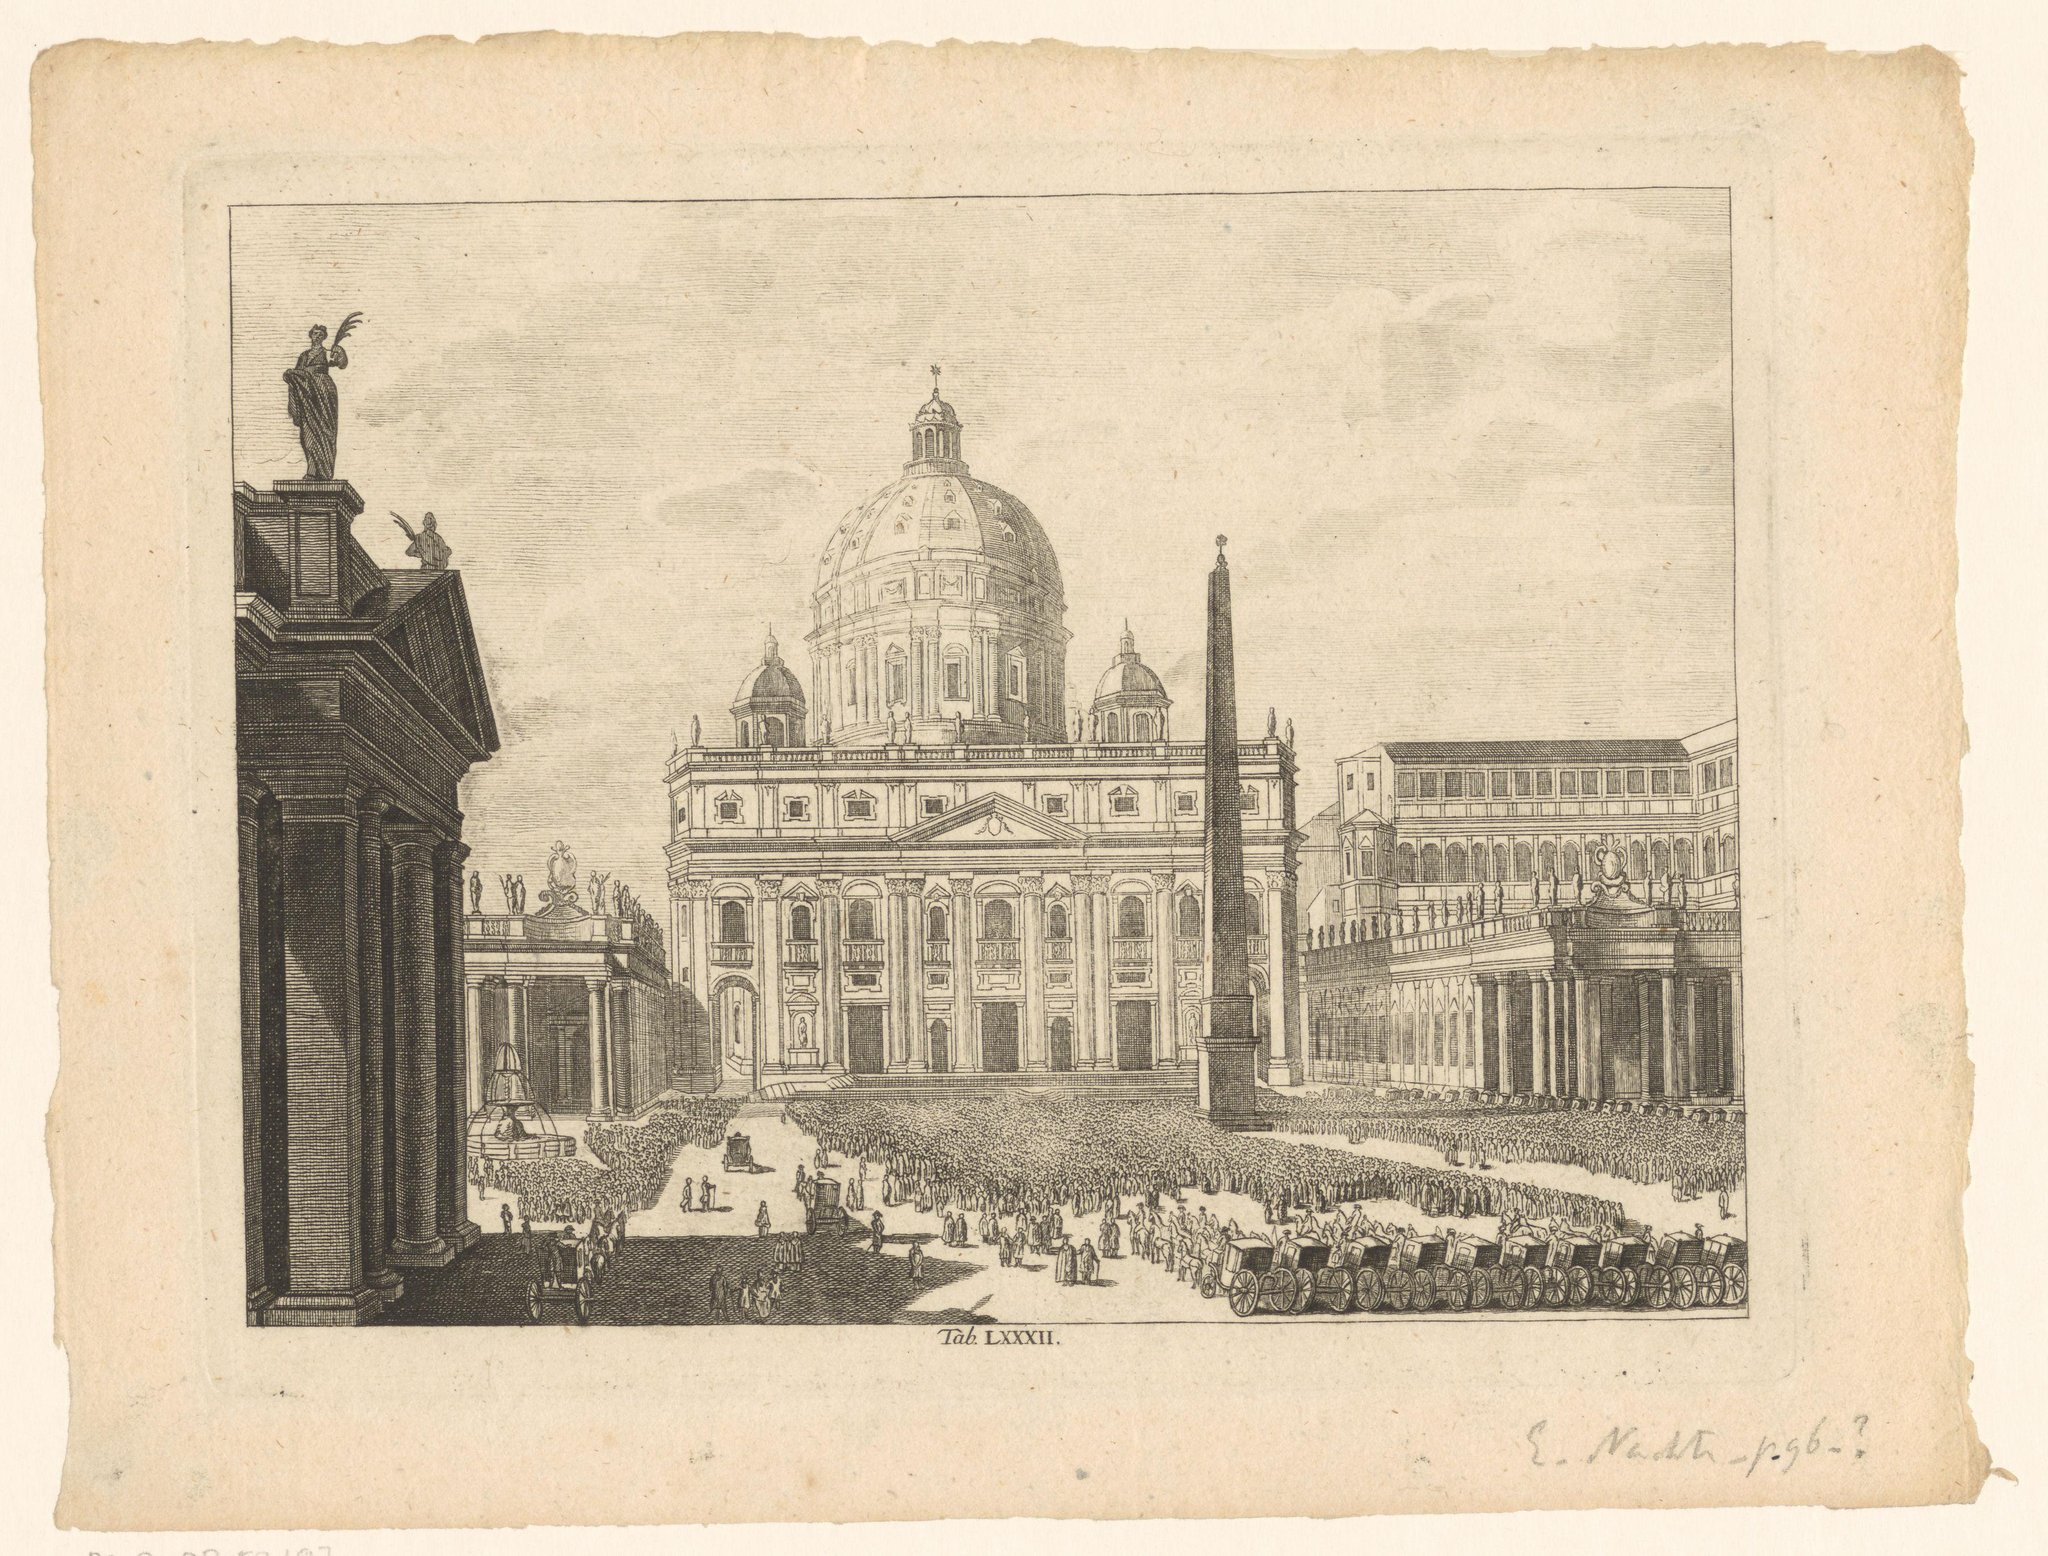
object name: print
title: Gezicht op façade van de Sint-Pietersbasiliek en het Sint-Pietersplein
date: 1774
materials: paper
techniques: etching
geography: leipzig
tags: parts of church exterior and annexes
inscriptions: collector's mark: Lugt 2228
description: Prent uit: Basedow, Johann Bernhard. Kupfersammlung zu J.B. Basedows Elementarwerke für die Jugend und ihre Freunde (...). Berlijn en Dessau: s.n., 1774.